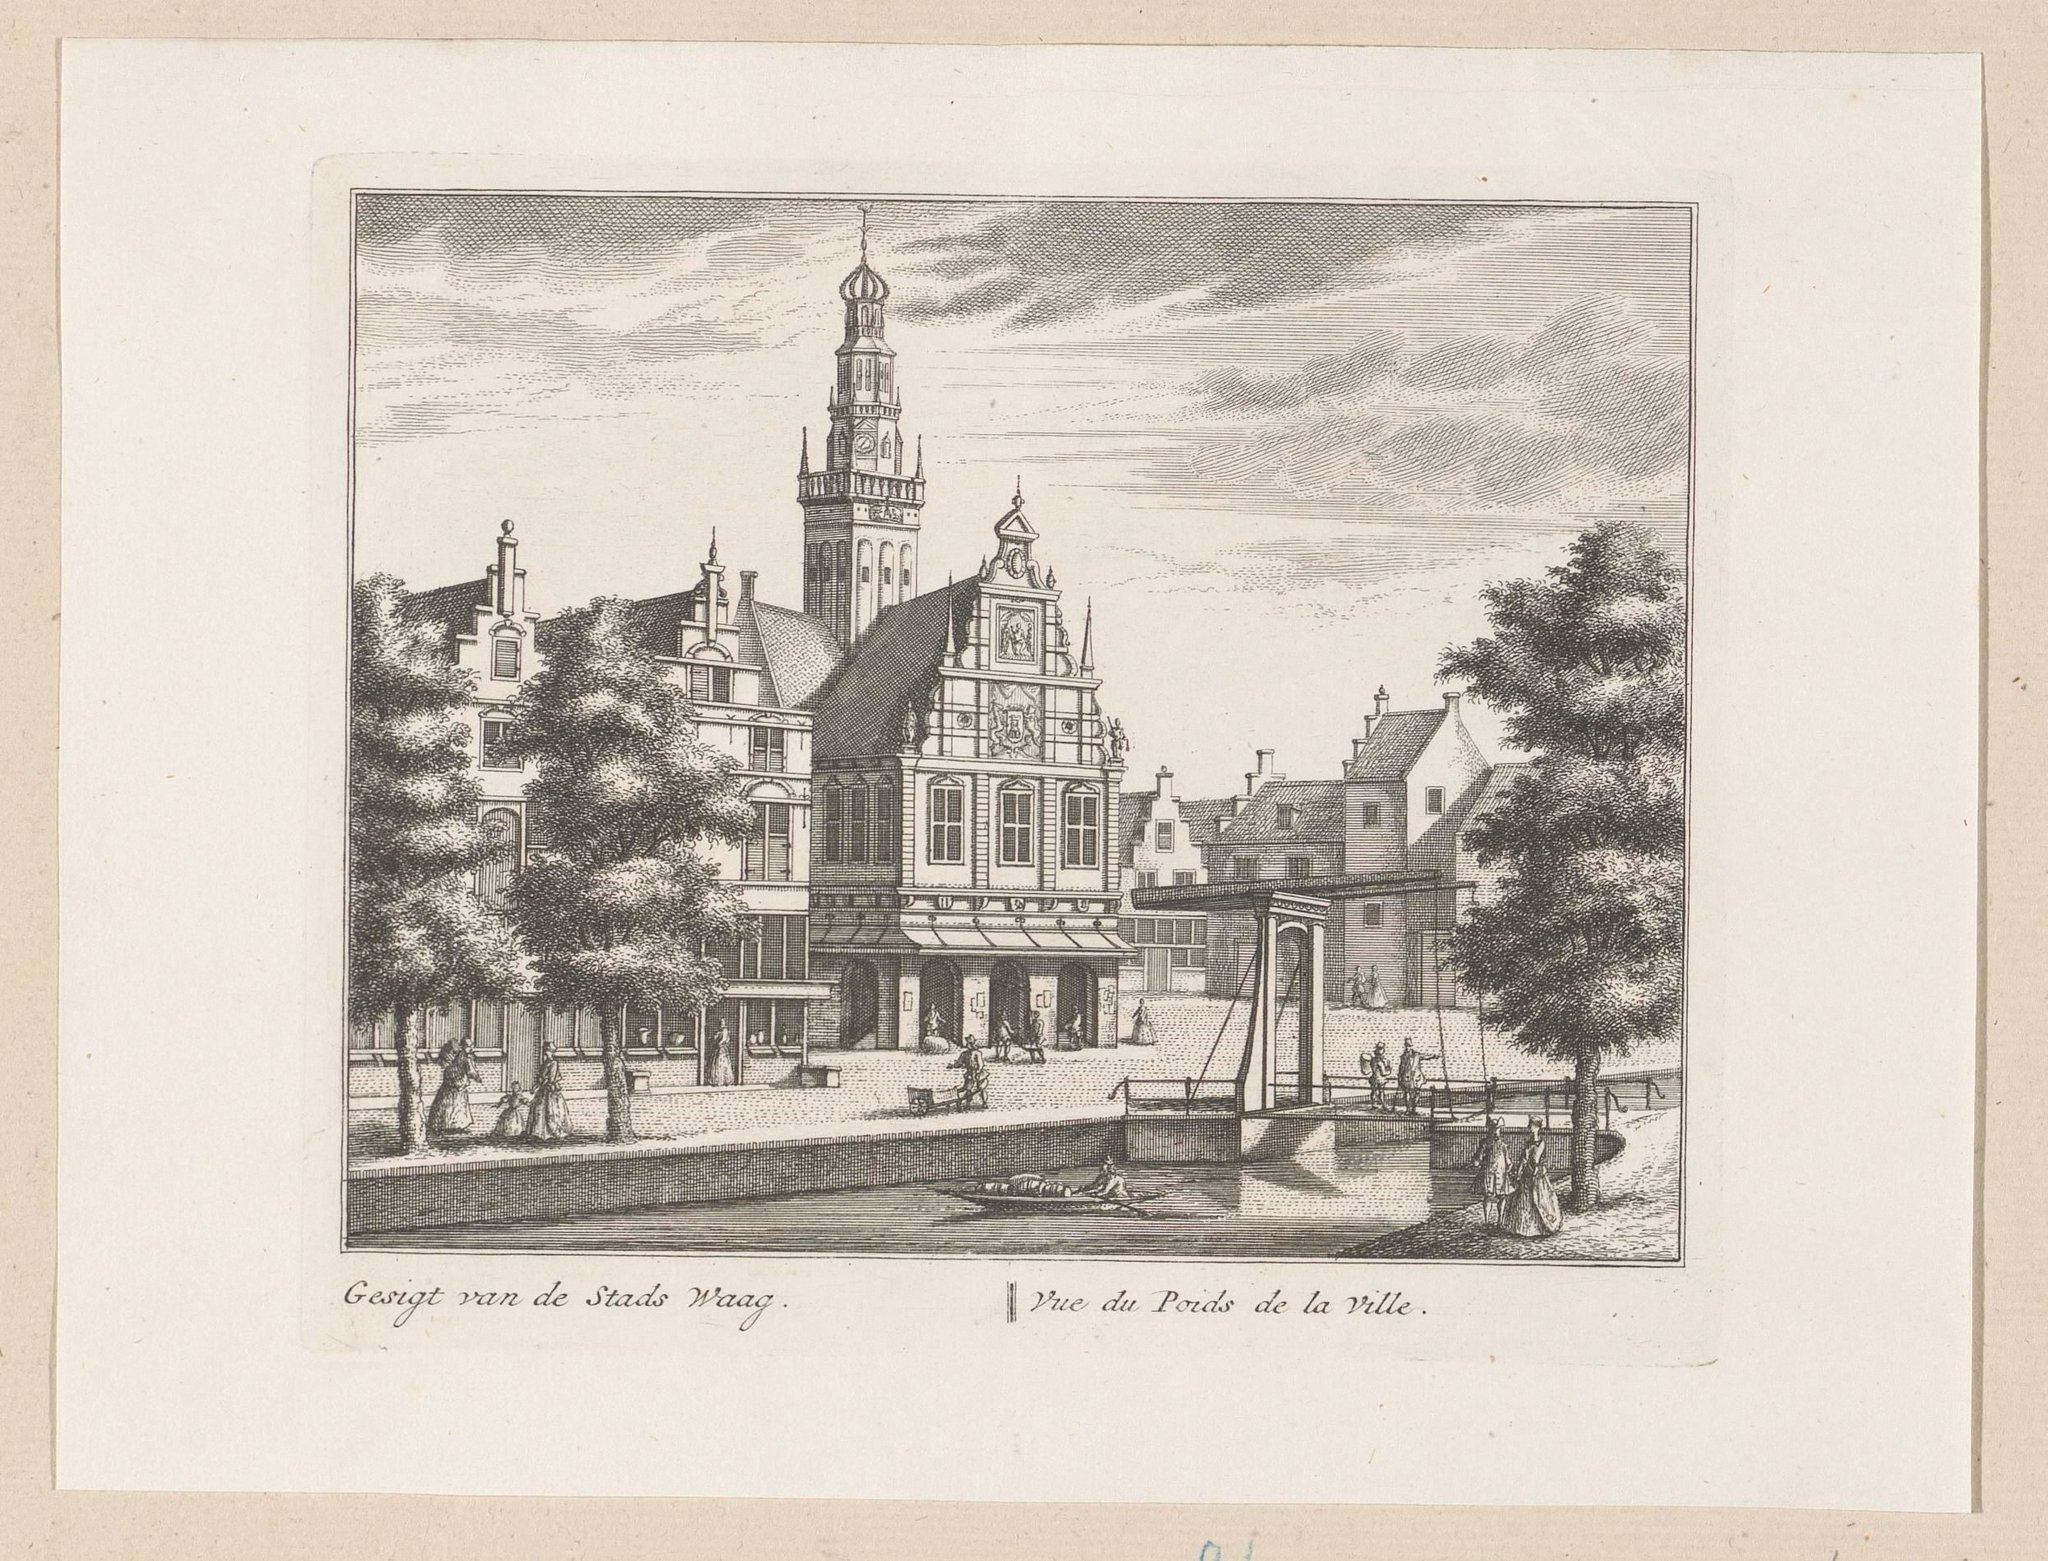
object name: print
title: Alle de voornaamste gesigten van de stadt Alckmaar geleegen in West-Vriesland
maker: leonard schenk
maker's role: print maker, publisher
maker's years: 1696-1767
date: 1736-1746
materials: paper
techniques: etching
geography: northern netherlands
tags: rowing-boat, canoe, etc., bridge, weigh-house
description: Als onderdeel van een prentserie van gezichten op Alkmaar in een publicatie met drie prentseries van stadsgezichten (op Alkmaar, Delft en Dordrecht) is deze prent ook gebruikt in: Rademaker, Abraham. Alle de voornaamste gesigten van de wydberoemde steeden Alkmaar, Delft en Dordregt (...) / Toutes les principales vuës de la fameuse villes d'Alcmar, Delft & Dordregt (…). Amsterdam: Leonard Schenk, 1736. Als illustratie is deze prent ook gebruikt in: Woude, C. van der. Kronyck van Alckmaar. Met zyn dorpen (…). 2e druk. Amsterdam: Steven van Esveldt, 1743. En in: Woude, C. van der. Kronyck van Alckmaar. Met zyn dorpen (…). 2e druk. Den Haag: Johannes de Cros, 1746. Uit welke druk het huidige exemplaar precies komt is niet na te gaan.